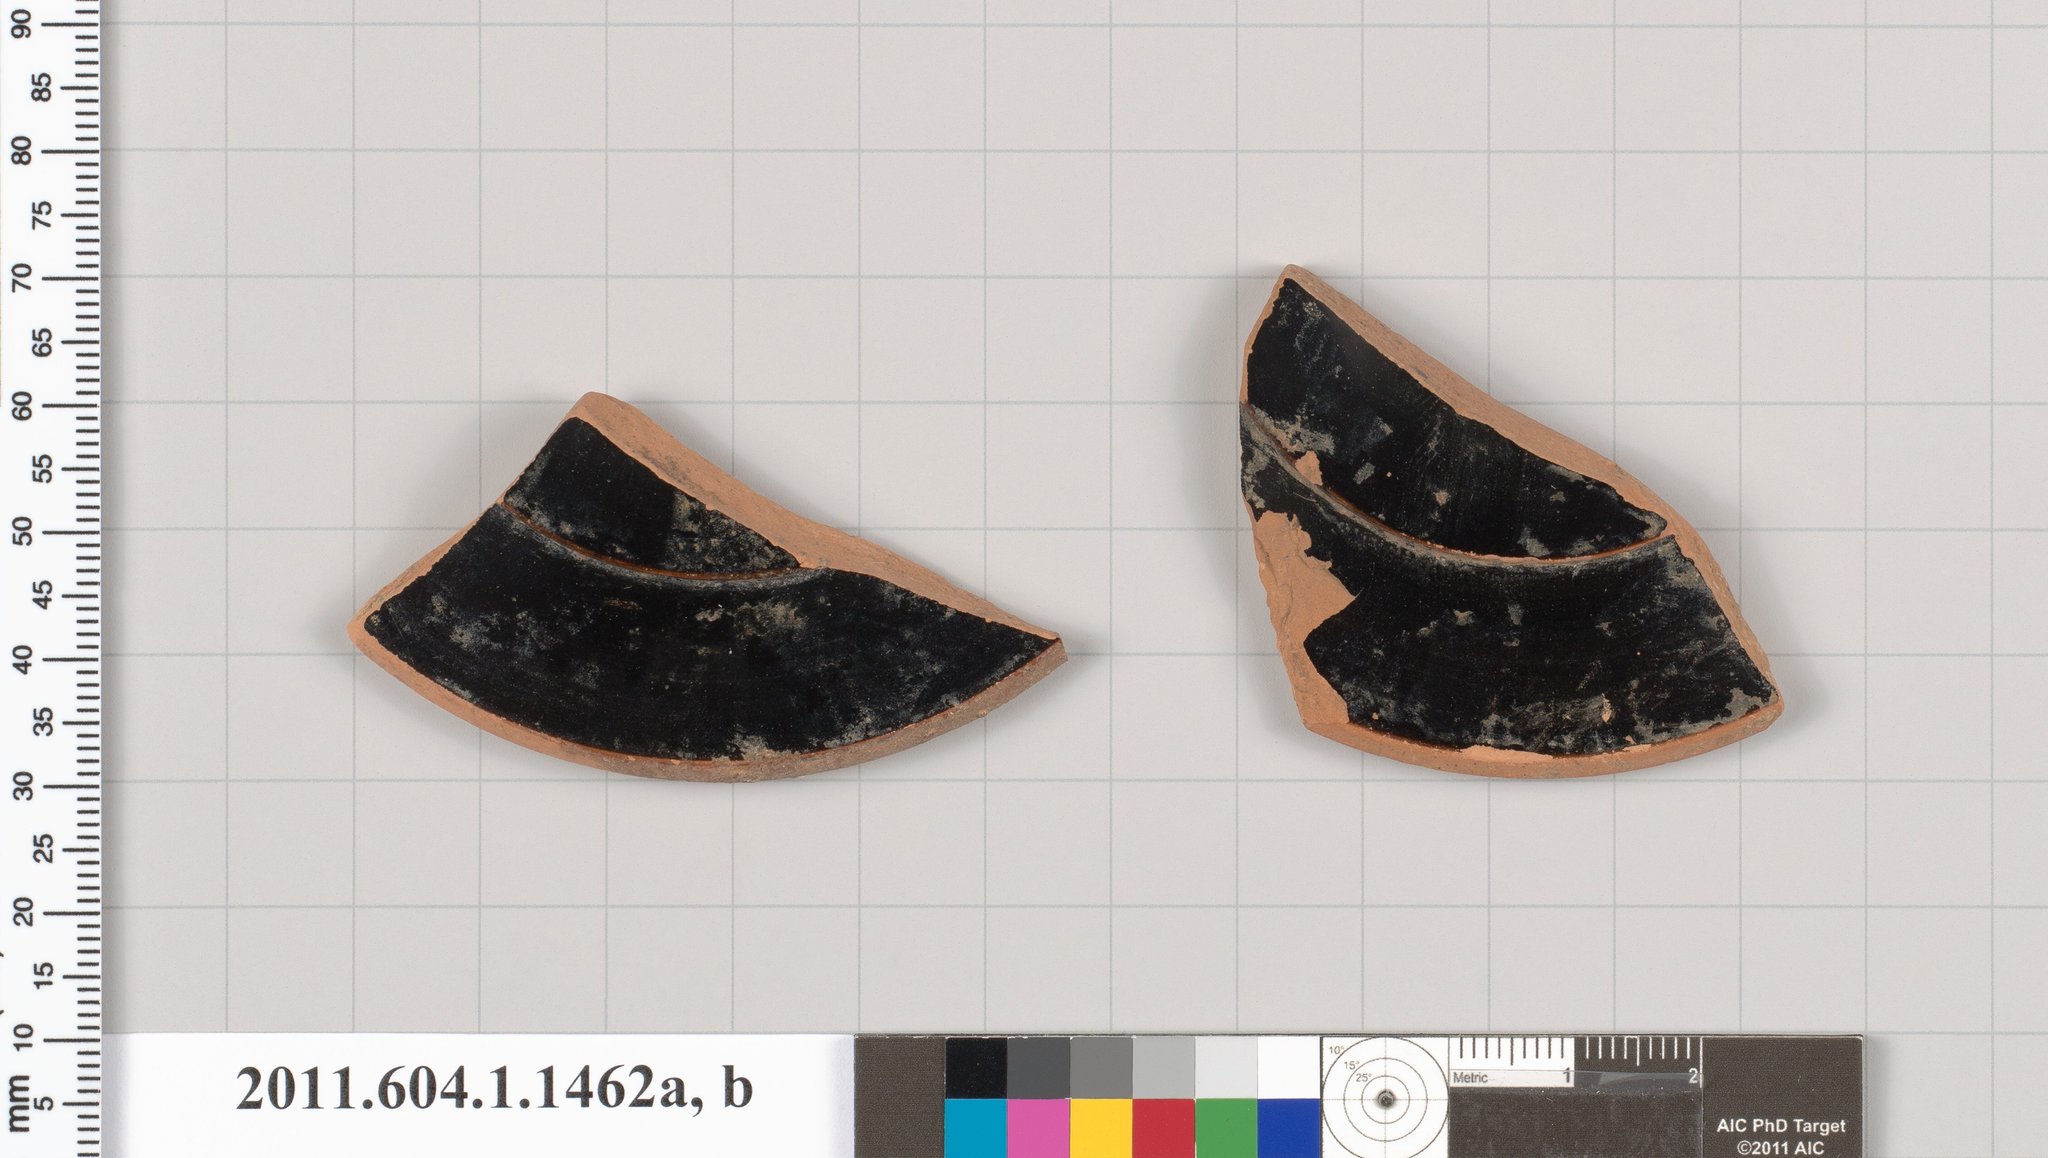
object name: kylix fragment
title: Terracotta fragments of a kylix (drinking cup)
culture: greek, attic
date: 500-401 BCE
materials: terracotta